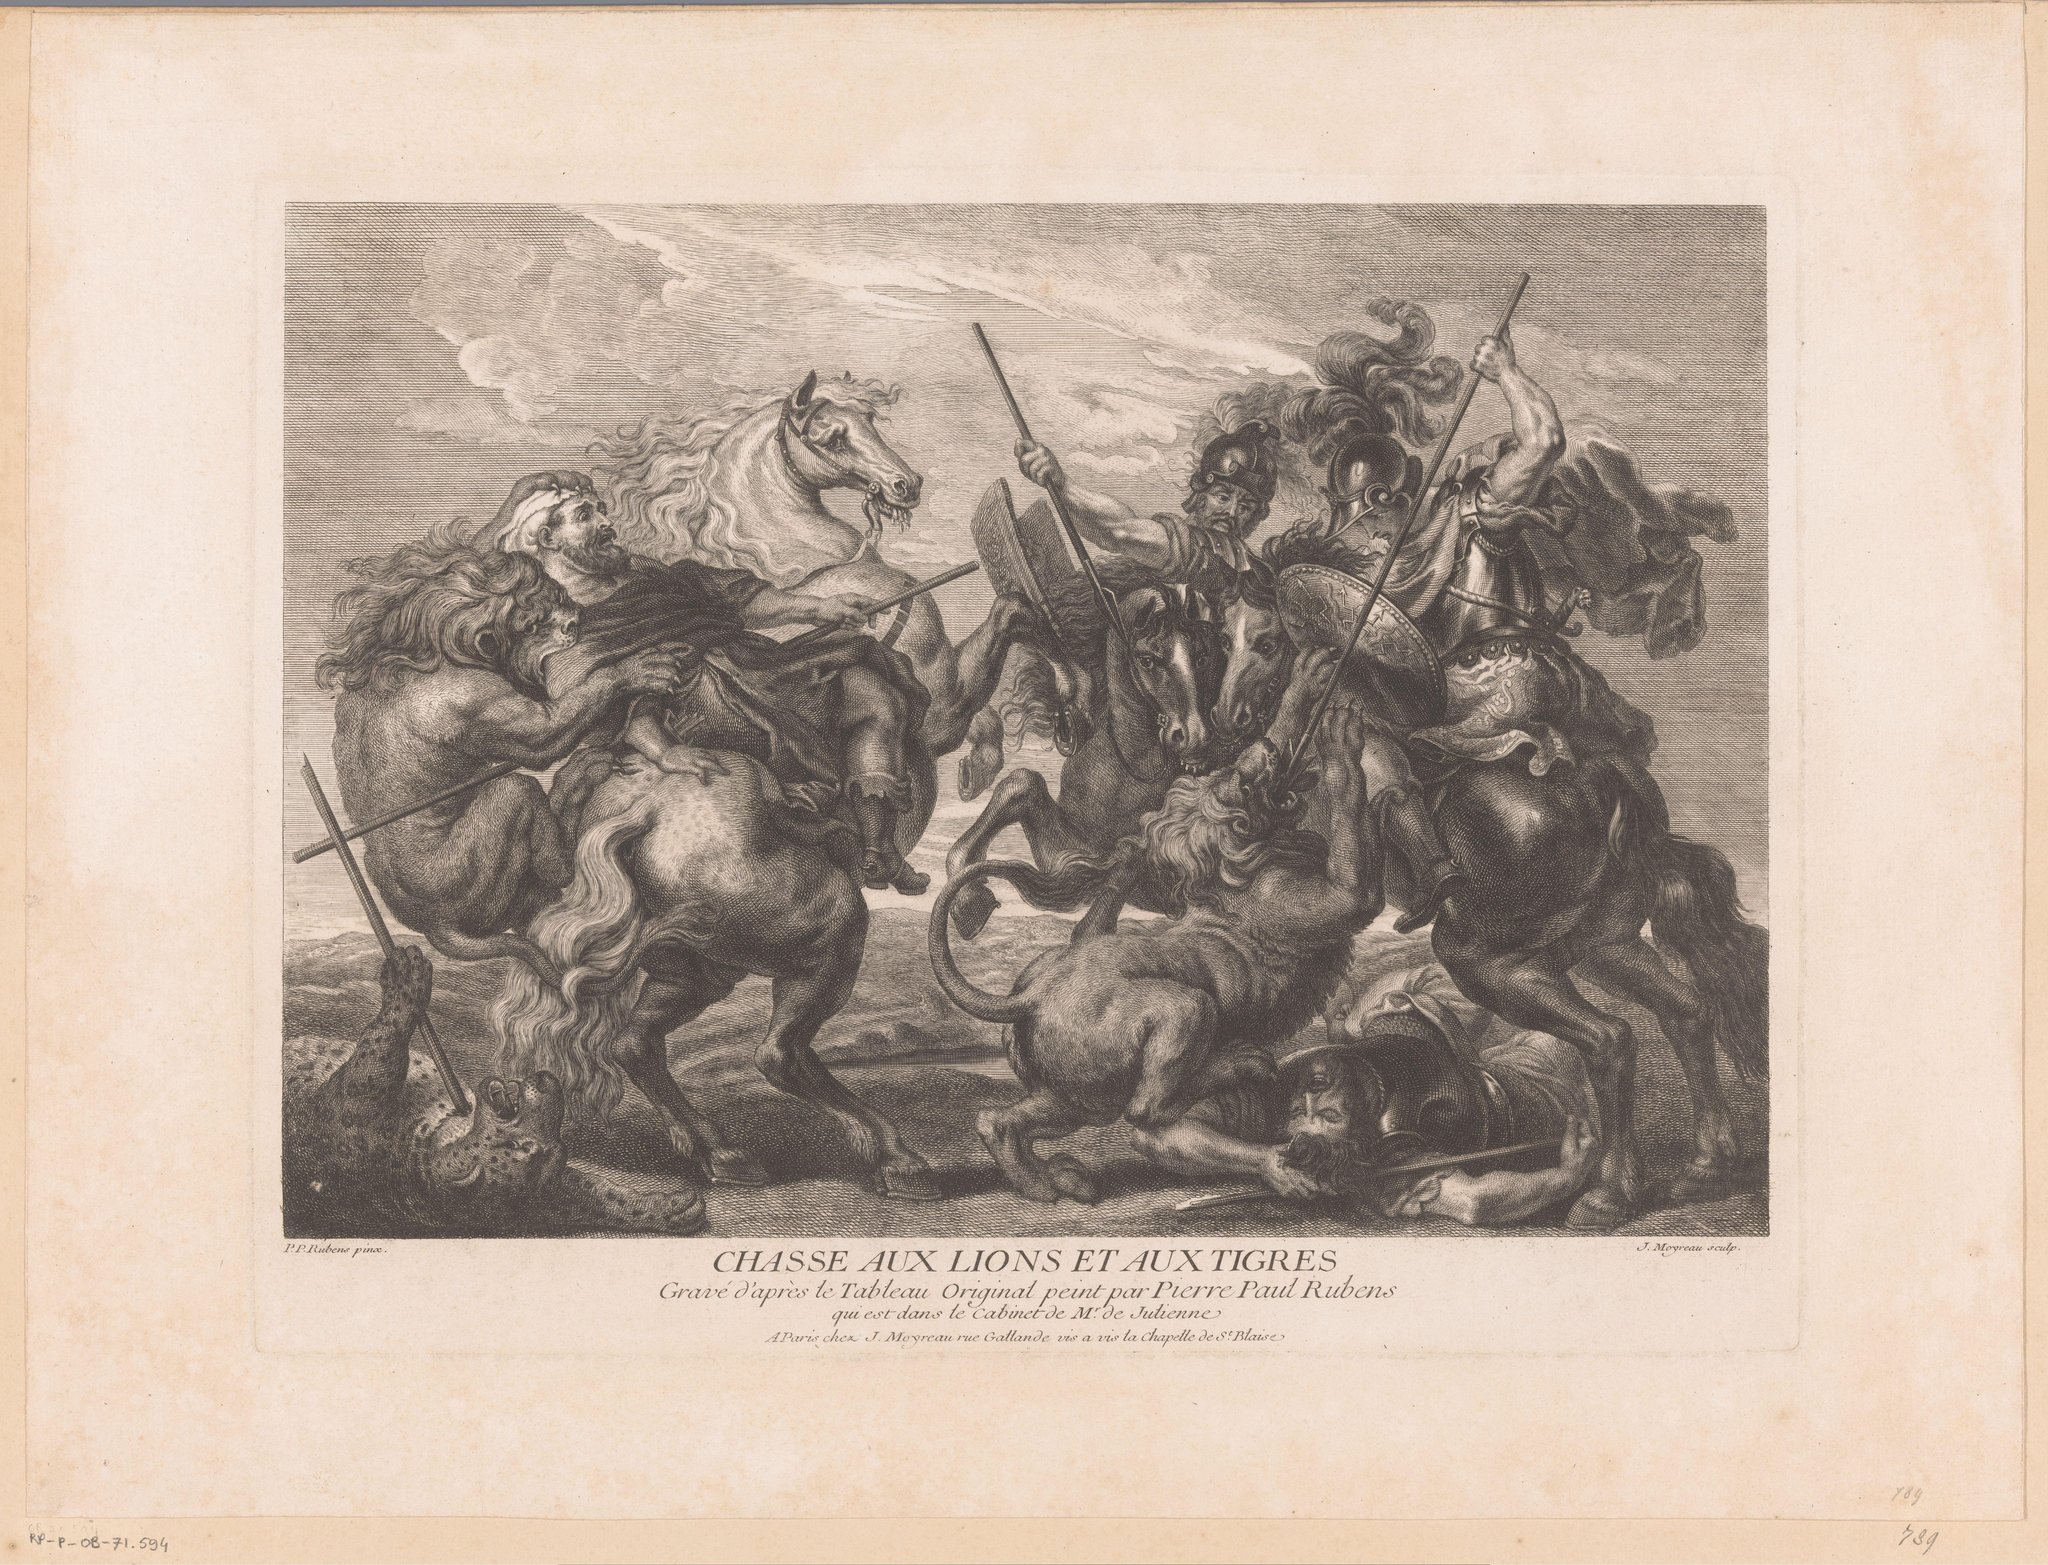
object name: print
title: Chasse aux Lions et aux Tigres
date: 1700-1762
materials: paper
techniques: engraving, etching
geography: paris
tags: beasts of prey, predatory animals: tiger, hunting, chase, lion hunt, beasts of prey, predatory animals: lion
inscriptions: collector's mark: Lugt 240